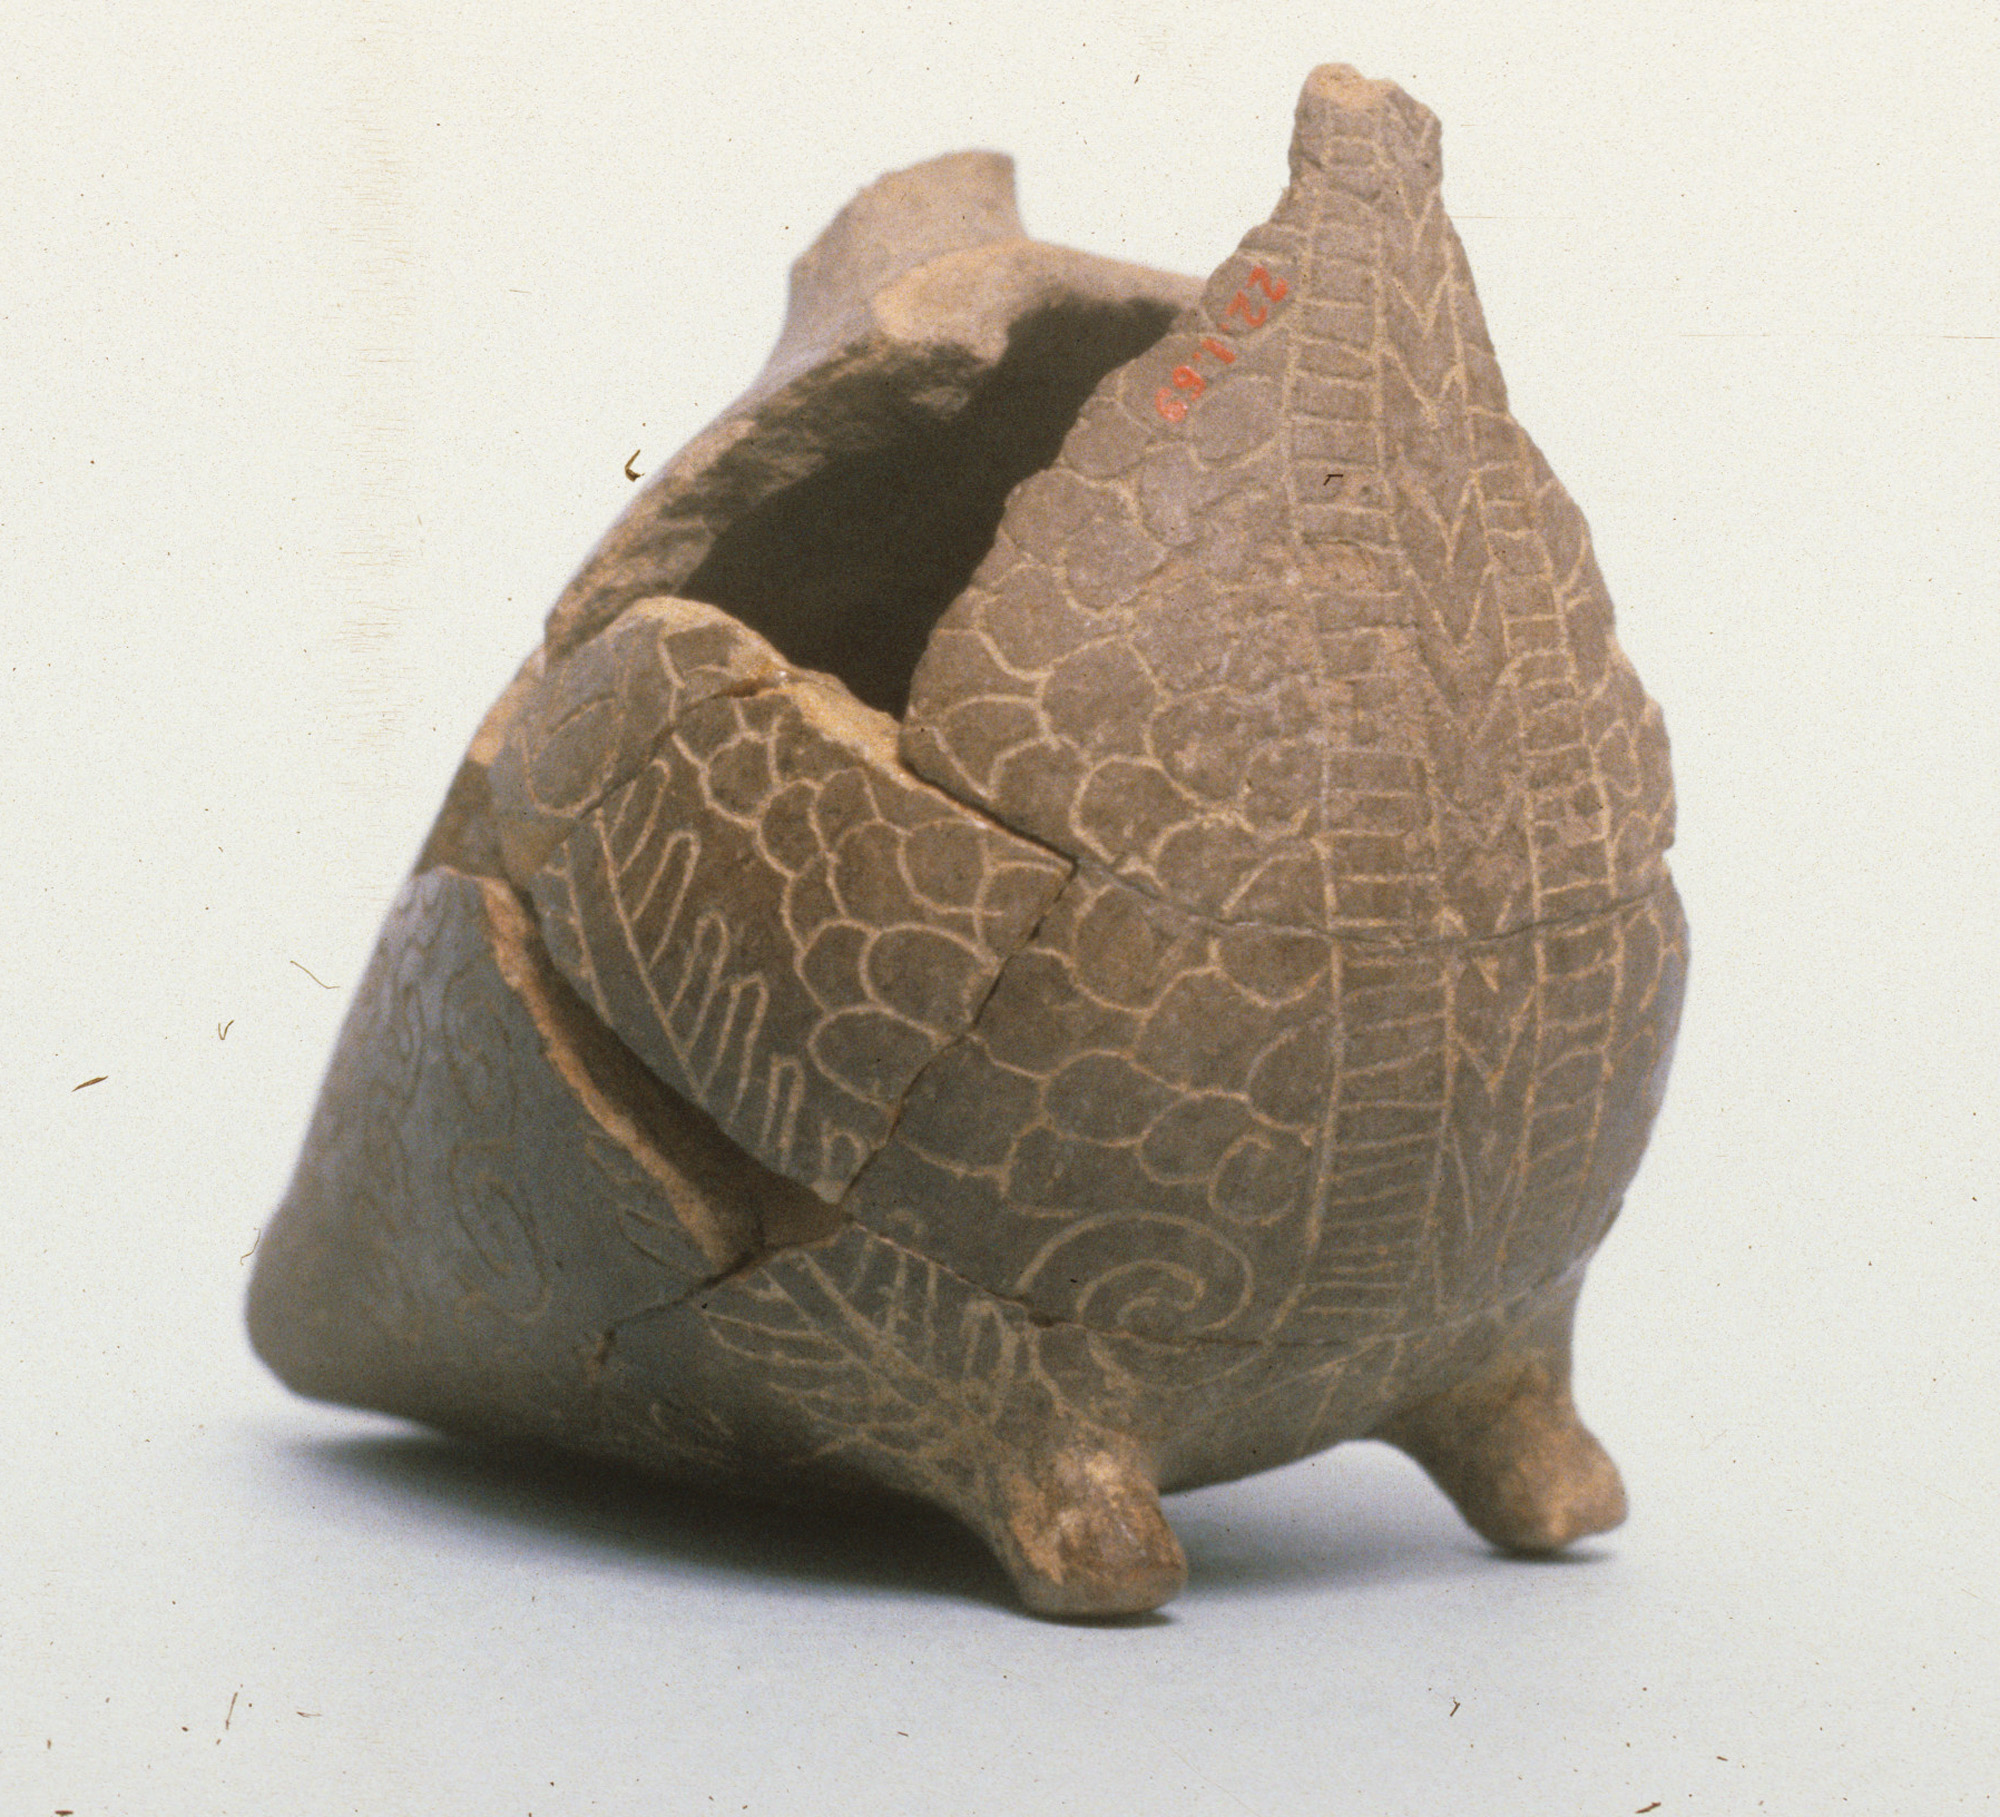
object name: jar, tell el yahudiya ware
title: Tell el-Yahudiya-ware jar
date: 1750-1600 BCE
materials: pottery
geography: egypt